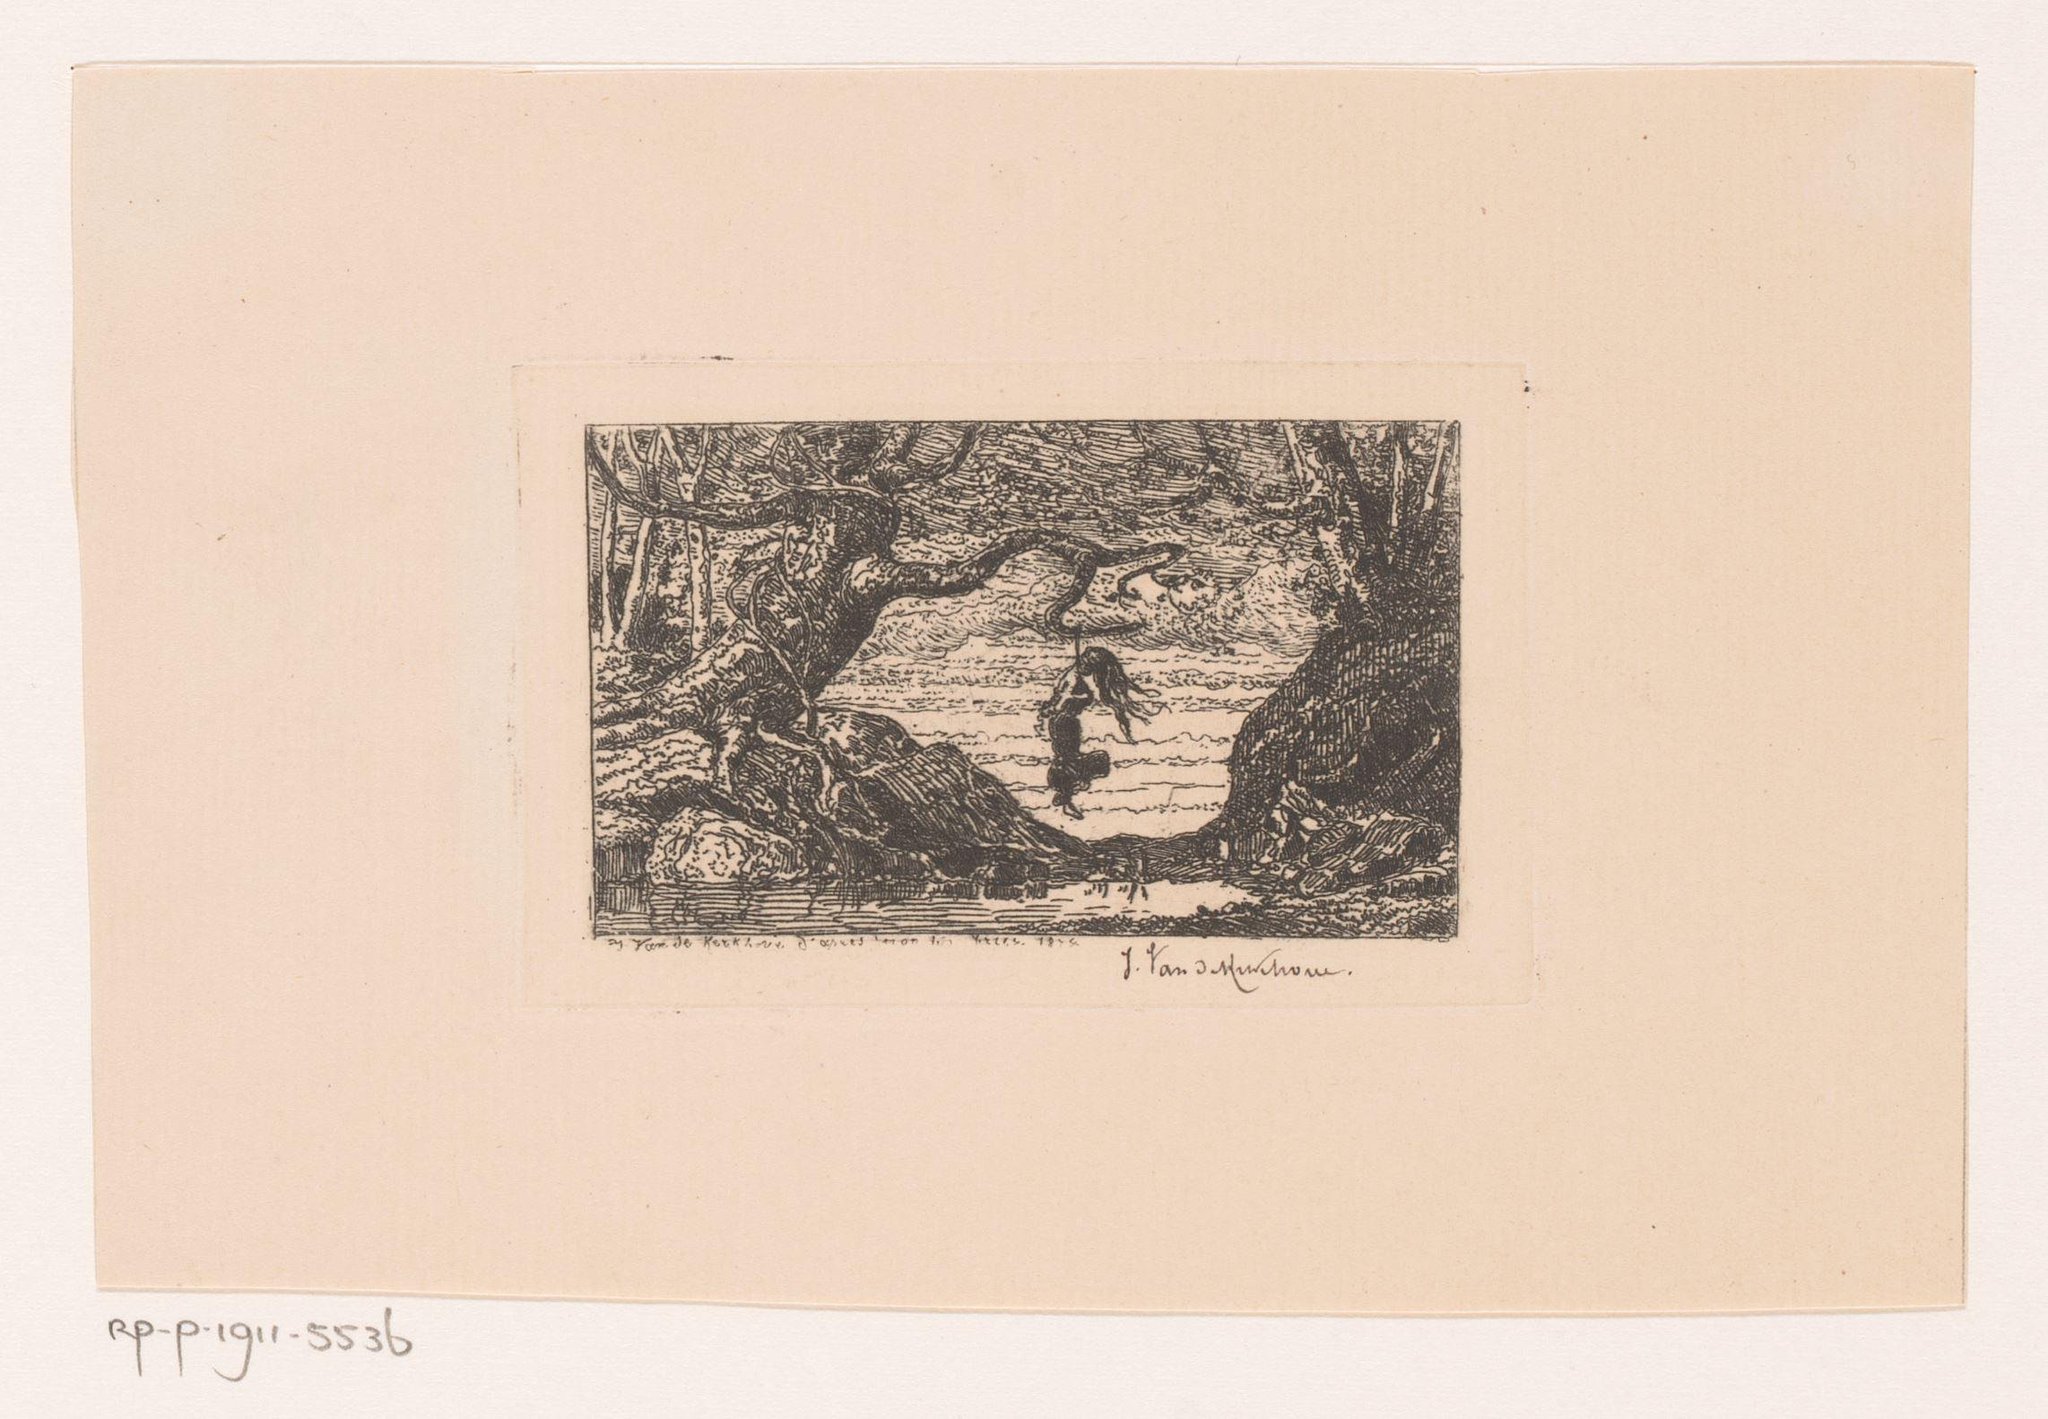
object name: print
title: Opgehangen vrouw aan een boom boven een meer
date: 1874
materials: paper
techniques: etching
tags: violent death by hanging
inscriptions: collector's mark: Lugt 2228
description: De etsen naar de schilderijen van Frédéric Van de Kerkhove werden na zijn dood door zijn vader en zuster gemaakt en uitgegeven in twee reeksen. De eerste werd in 1877 uitgegeven door het Journal des Beaux-Arts et de la Littérature: Cahier de 25 Eaux-fortes d'après Frédéric van de Kerkhove, gravées par son père et sa sœur. De tweede reeks van 126 etsen, ook in 1877, werd in Parijs uitgegeven bij A. Lévy onder de titel Cent eaux-fortes gravées par J. Van de Kerkhove d'après les tableaux de Frédéric Van de Kerkhove, mort en 1873 à l'âge de 10 ans et 11 mois.